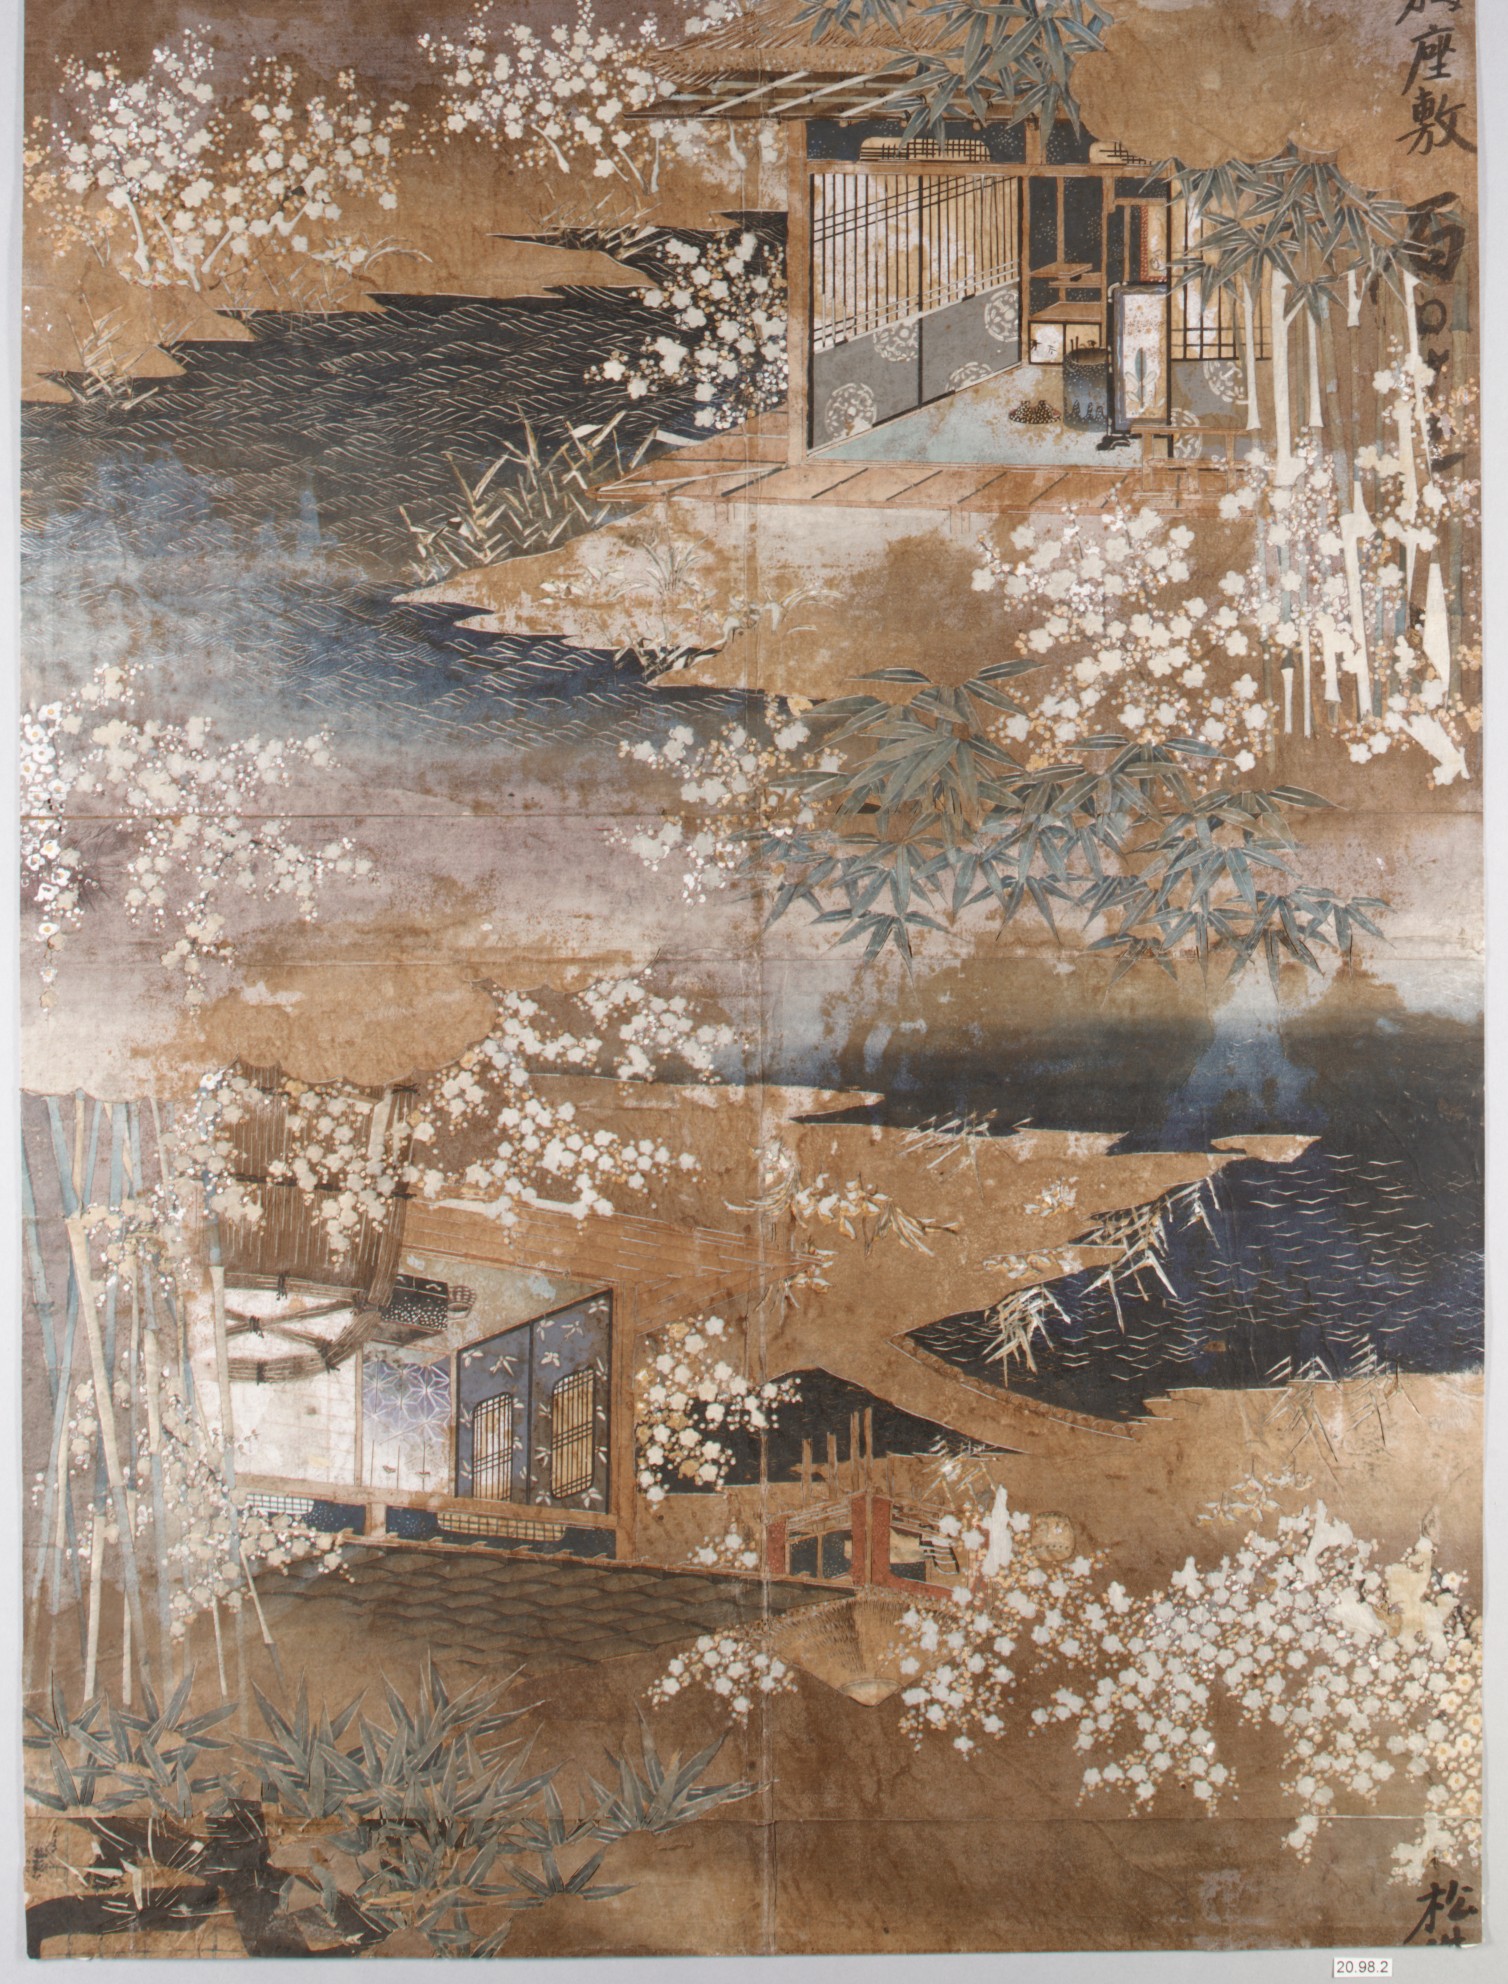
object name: textile design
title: Textile Design for Stencil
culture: japanese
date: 1601-1700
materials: paint, paper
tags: houses,flowers,landscapes